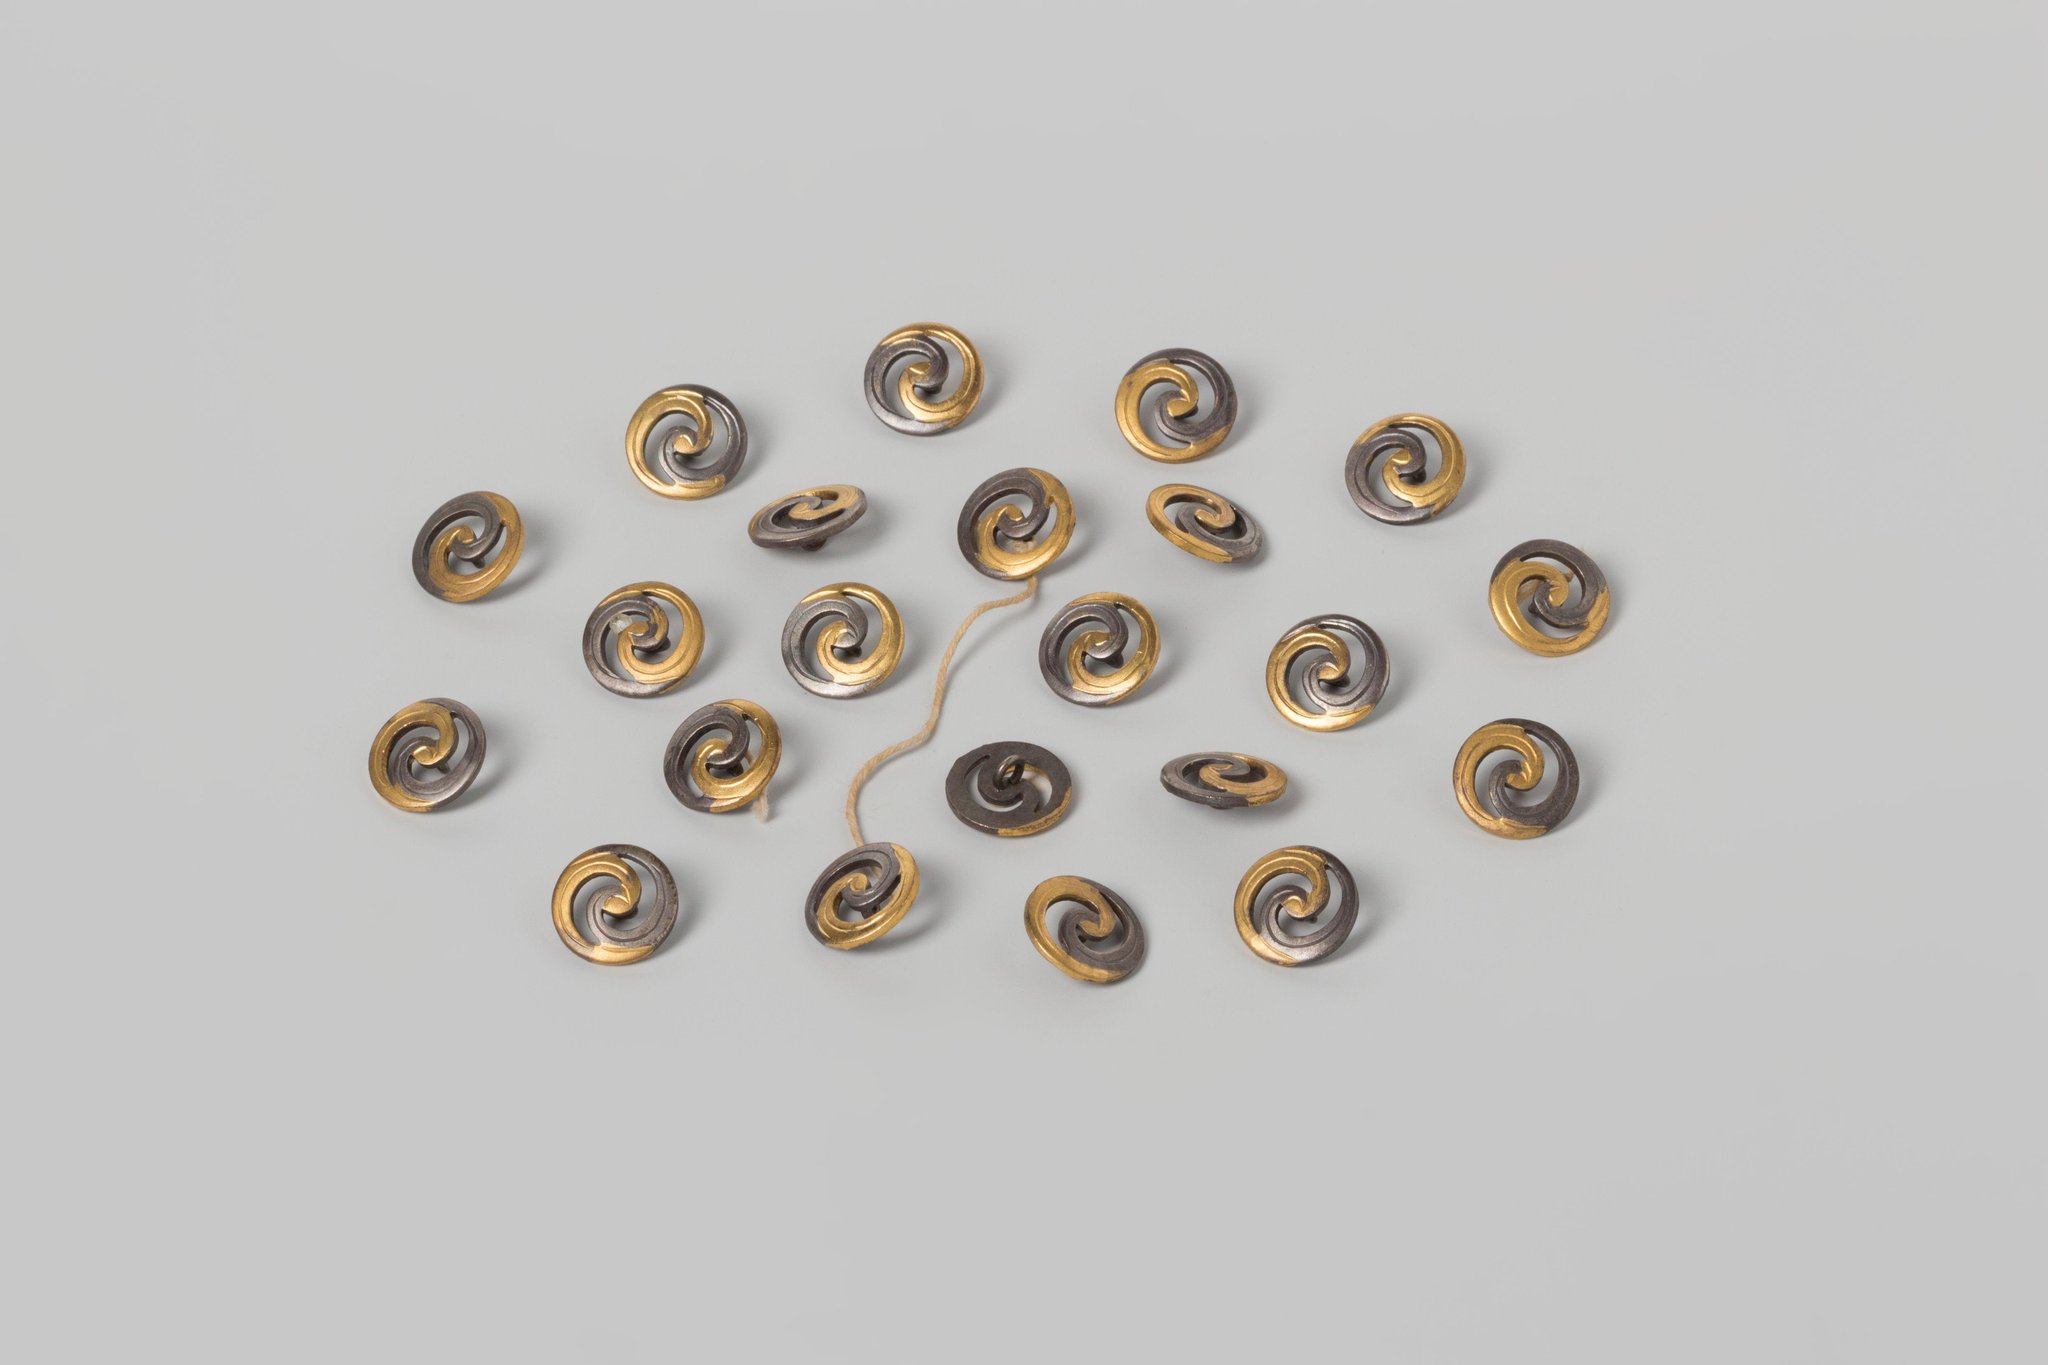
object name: clothing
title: Knoop, plat en rond, van gedeeltelijk met goudverf beschilderd metaal met krulmotief, gelijkend yin en yang, opengewerkt en gegraveerd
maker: Anonymous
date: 1880-1940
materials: paint, metal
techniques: embroidery, engraving, painting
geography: europe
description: Knoop, plat en rond, van gedeeltelijk met goudverf beschilderd metaal met krulmotief, gelijkend yin en yang, opengewerkt en gegraveerd.